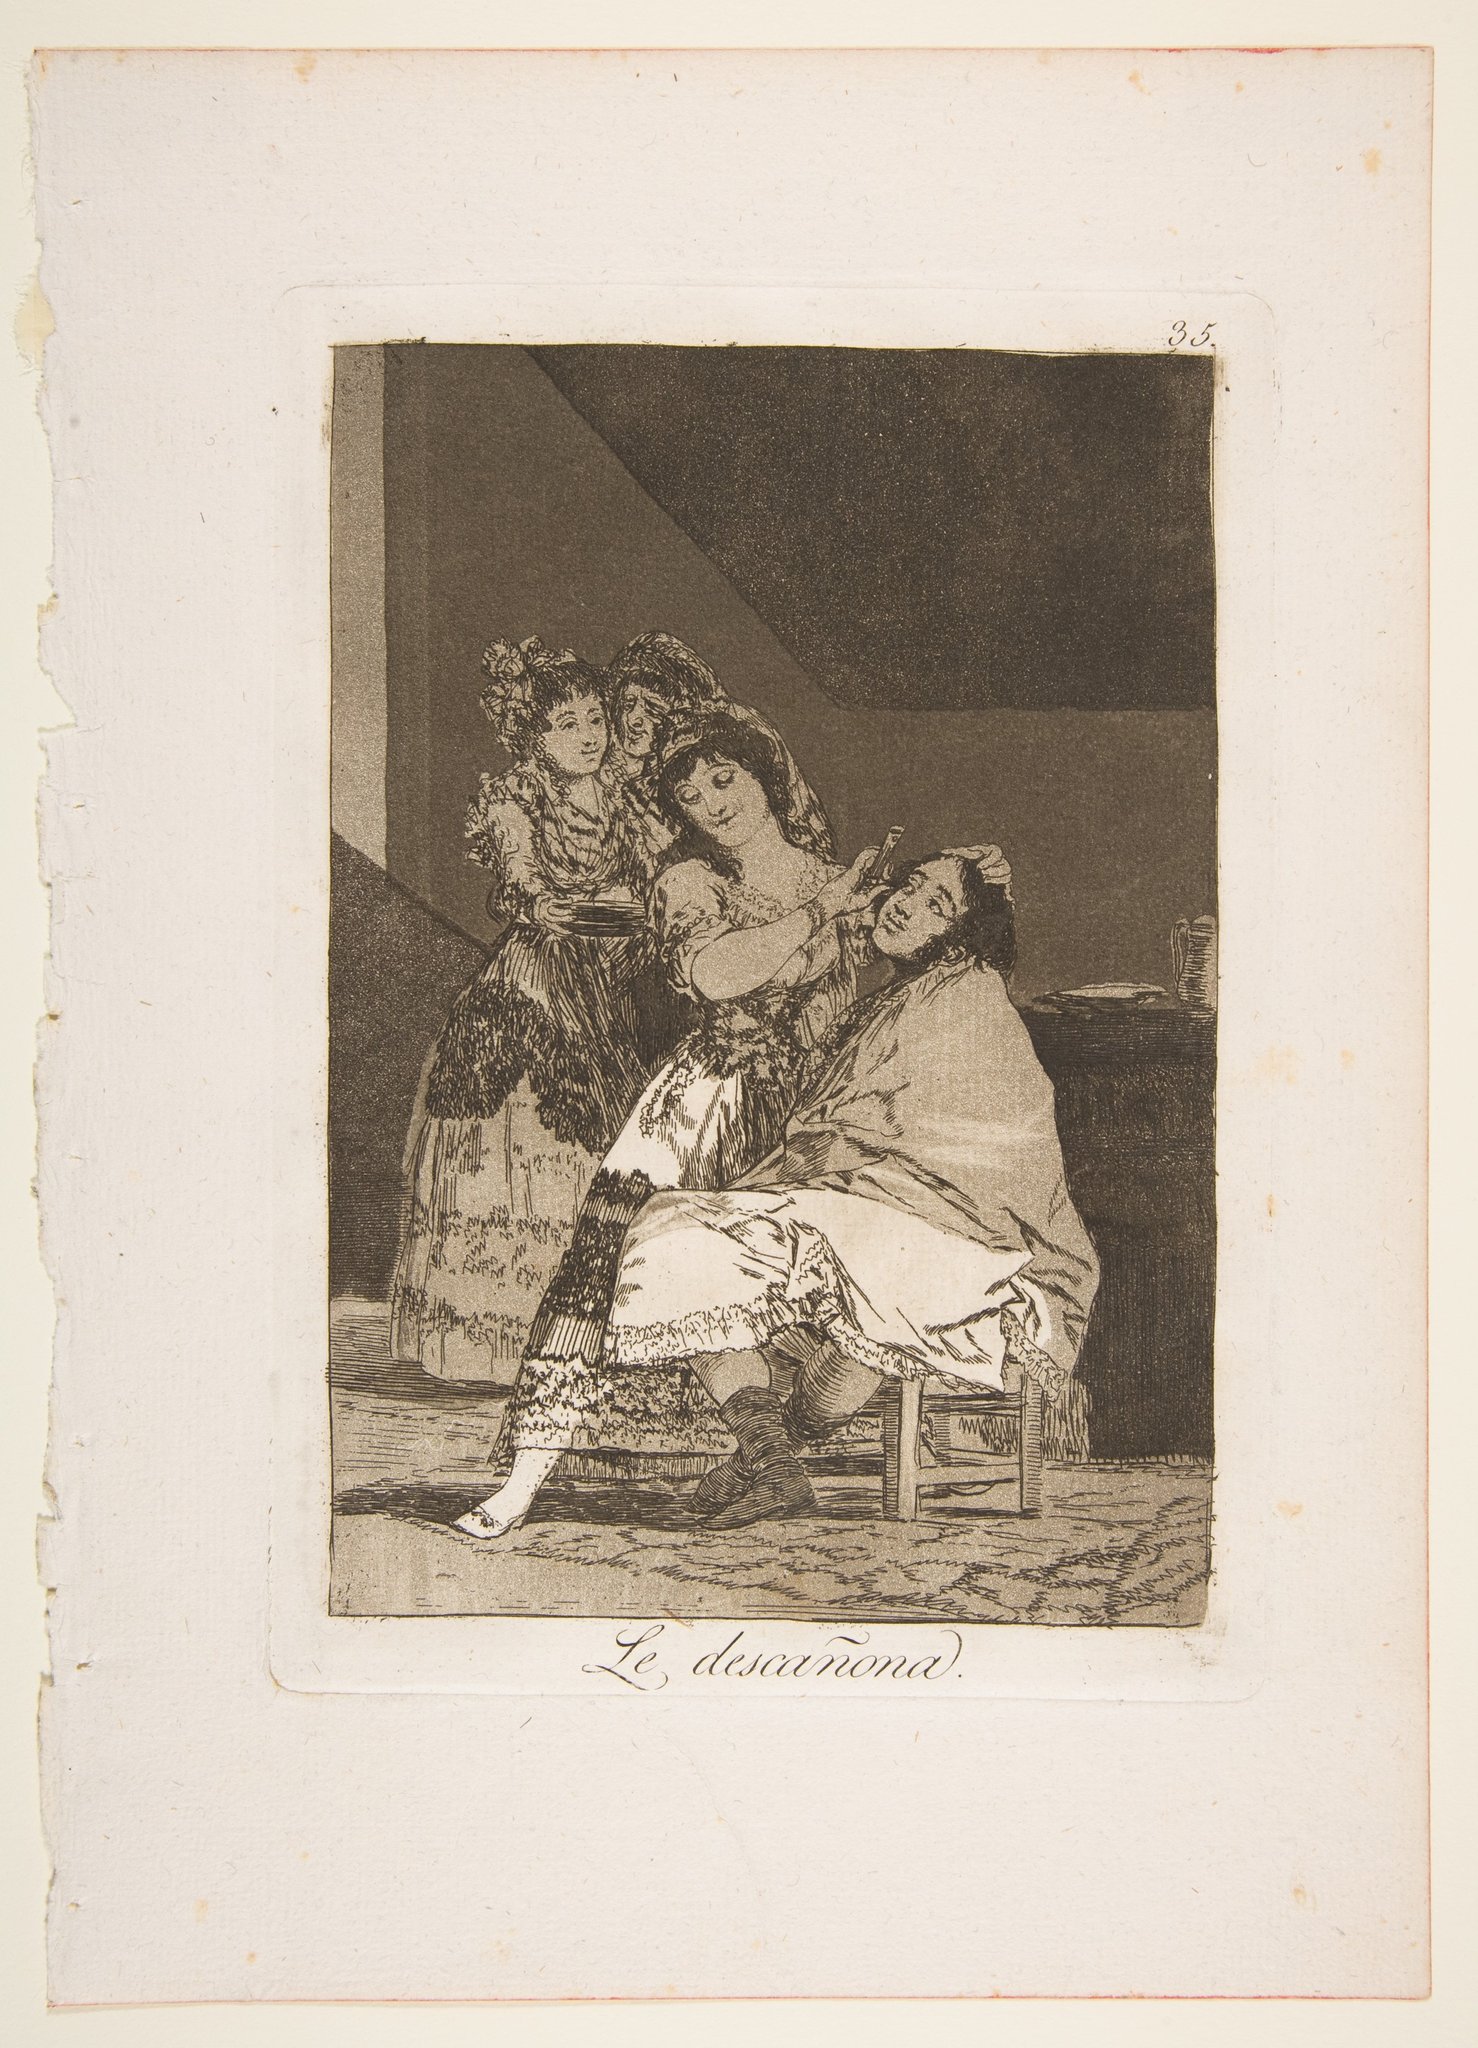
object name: print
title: Plate 35 from "Los Caprichos": She fleeces him (Le descañona)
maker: goya (francisco de goya y lucientes)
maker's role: artist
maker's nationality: spanish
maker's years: 1746-1828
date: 1799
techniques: aquatint, burnishing, etching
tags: women